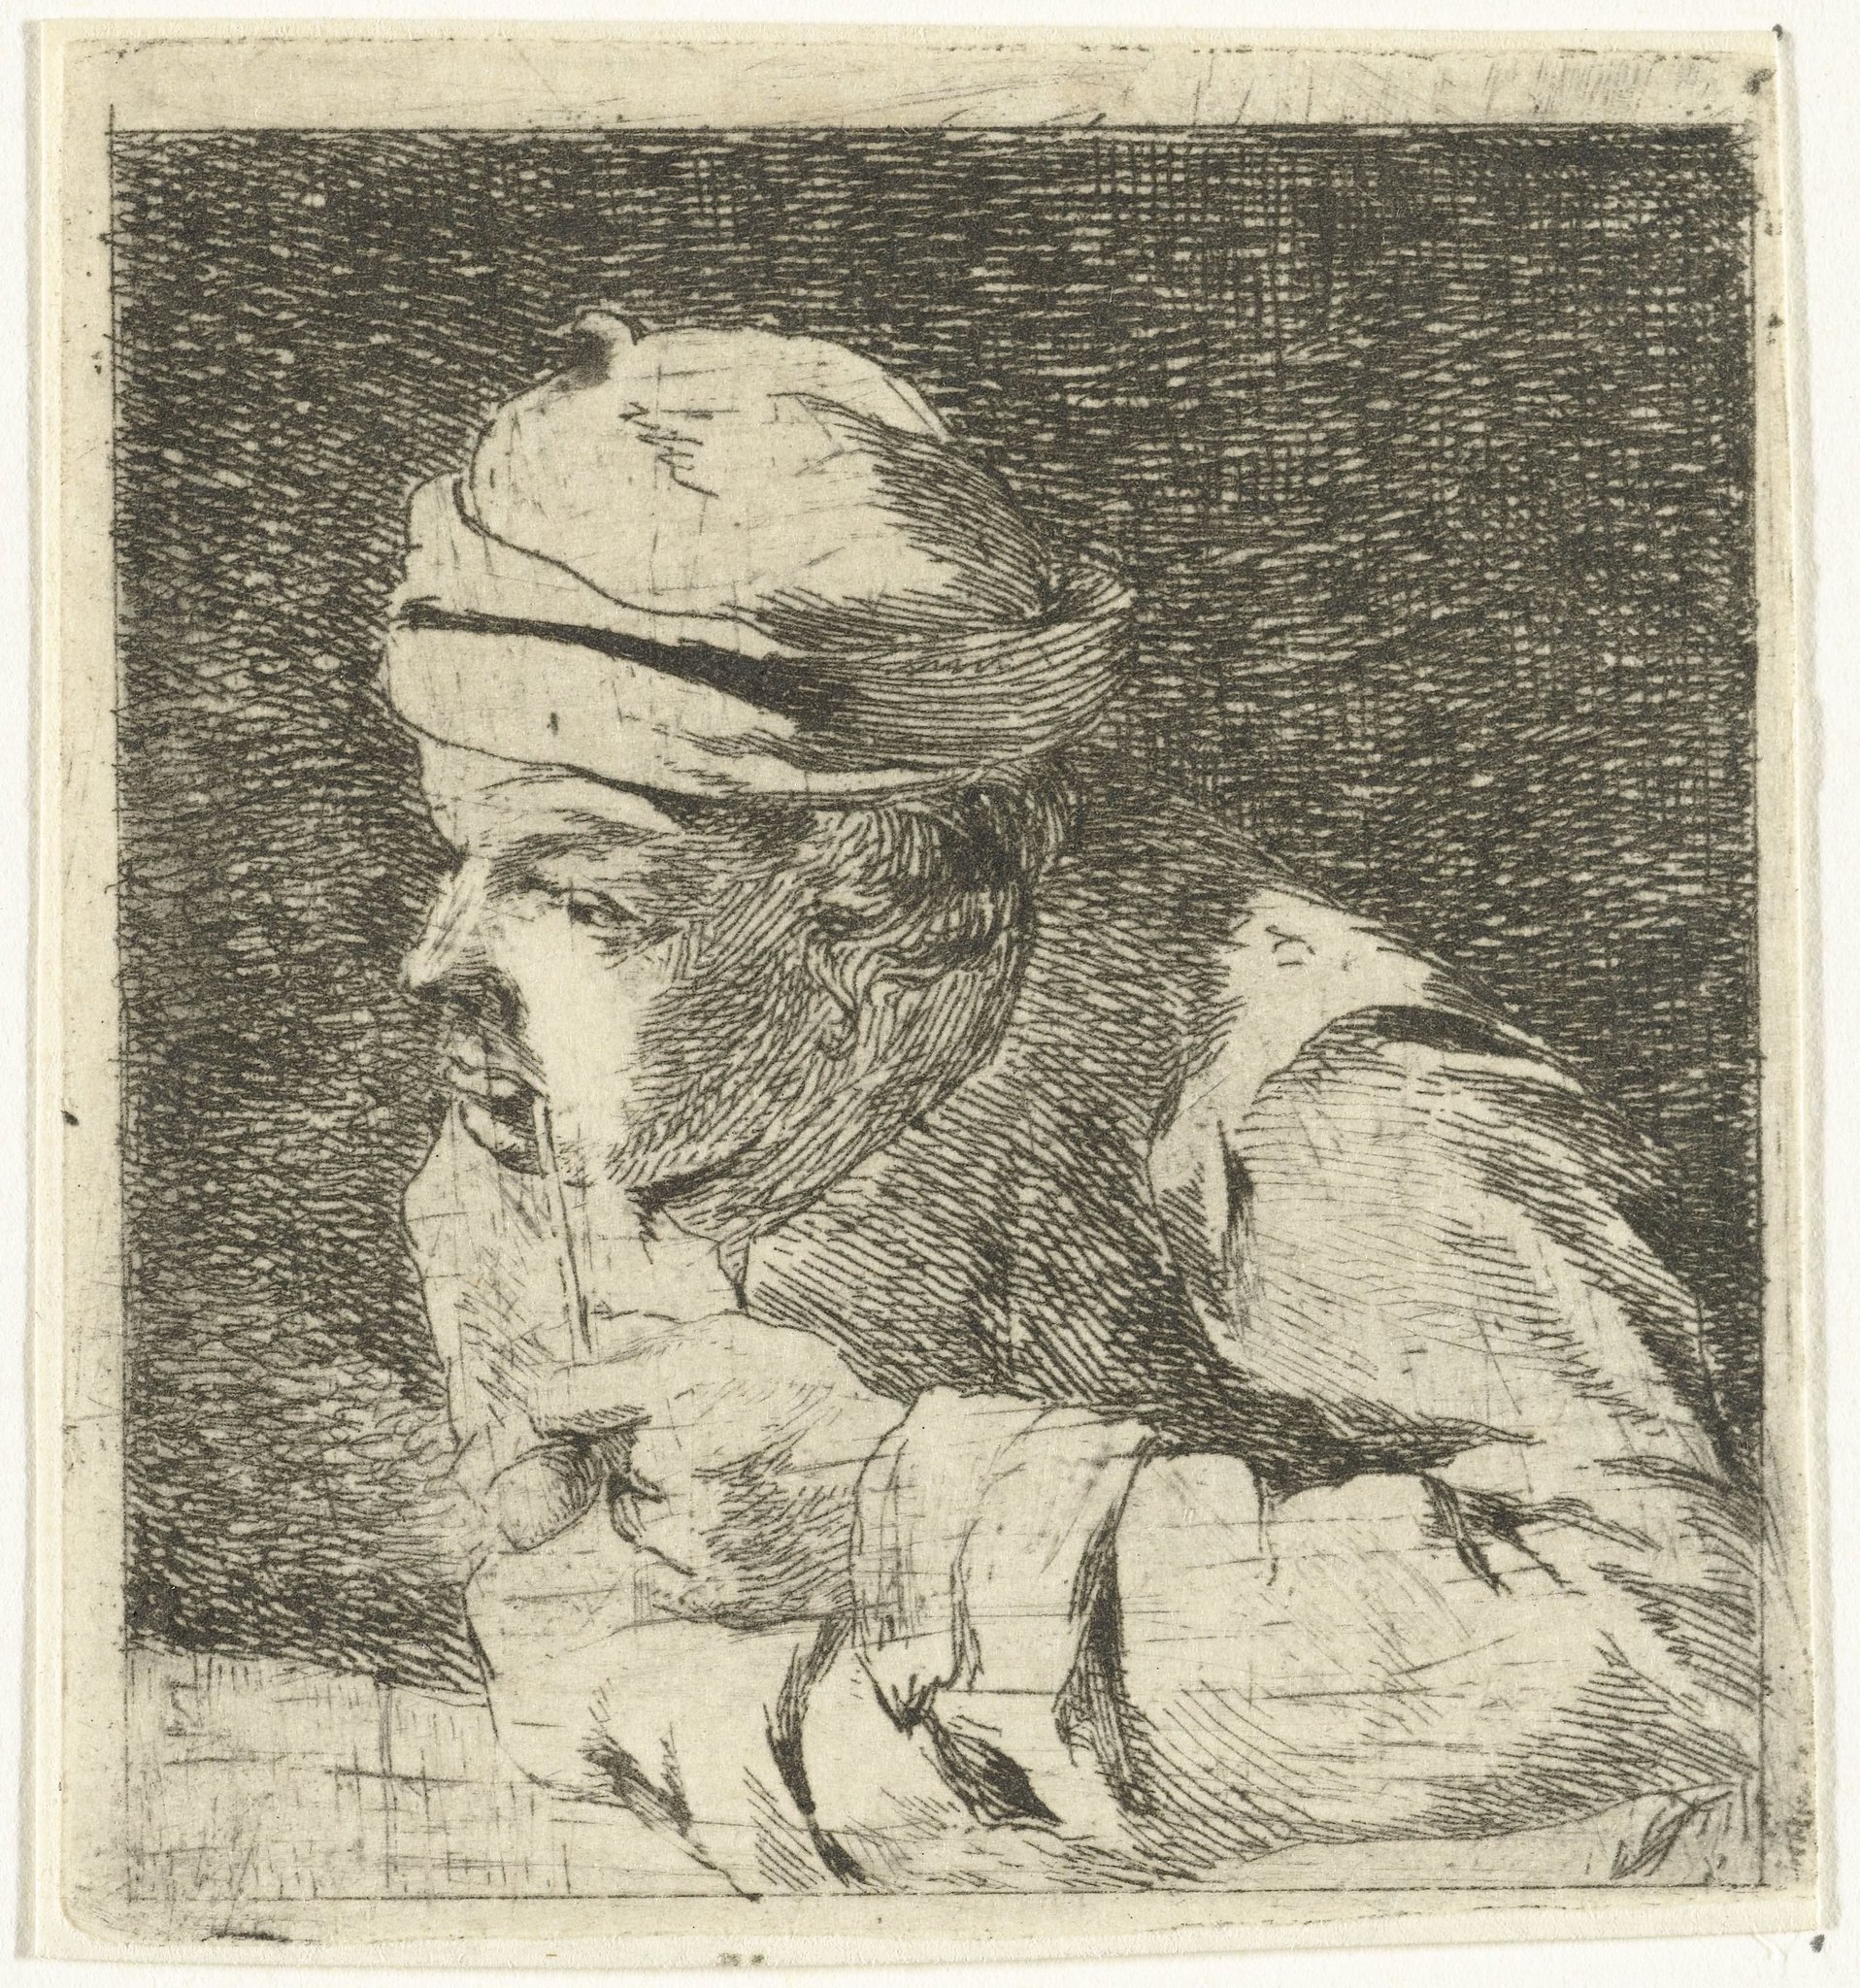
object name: print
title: Man met pijp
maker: hermanus van brussel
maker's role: draughtsman, print maker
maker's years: 1763-1815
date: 1778-1815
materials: paper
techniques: etching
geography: netherlands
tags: drinks, stimulants, drugs (+ taking (particular) foodstuffs: eating, drinking, smoking, chewing, etc.)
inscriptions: collector's mark: Lugt 2228